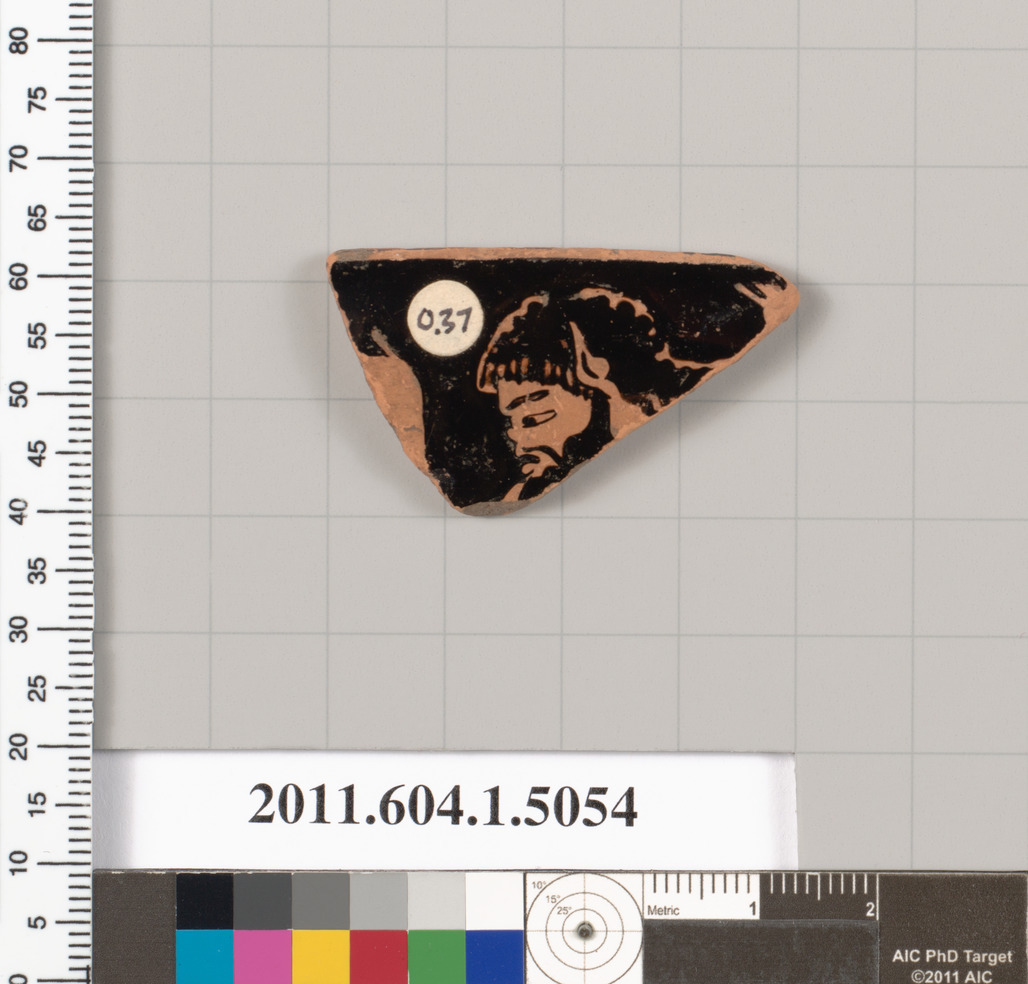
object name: kylix fragment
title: Terracotta fragment of a kylix (drinking cup)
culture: greek, attic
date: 520-500 BCE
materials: terracotta